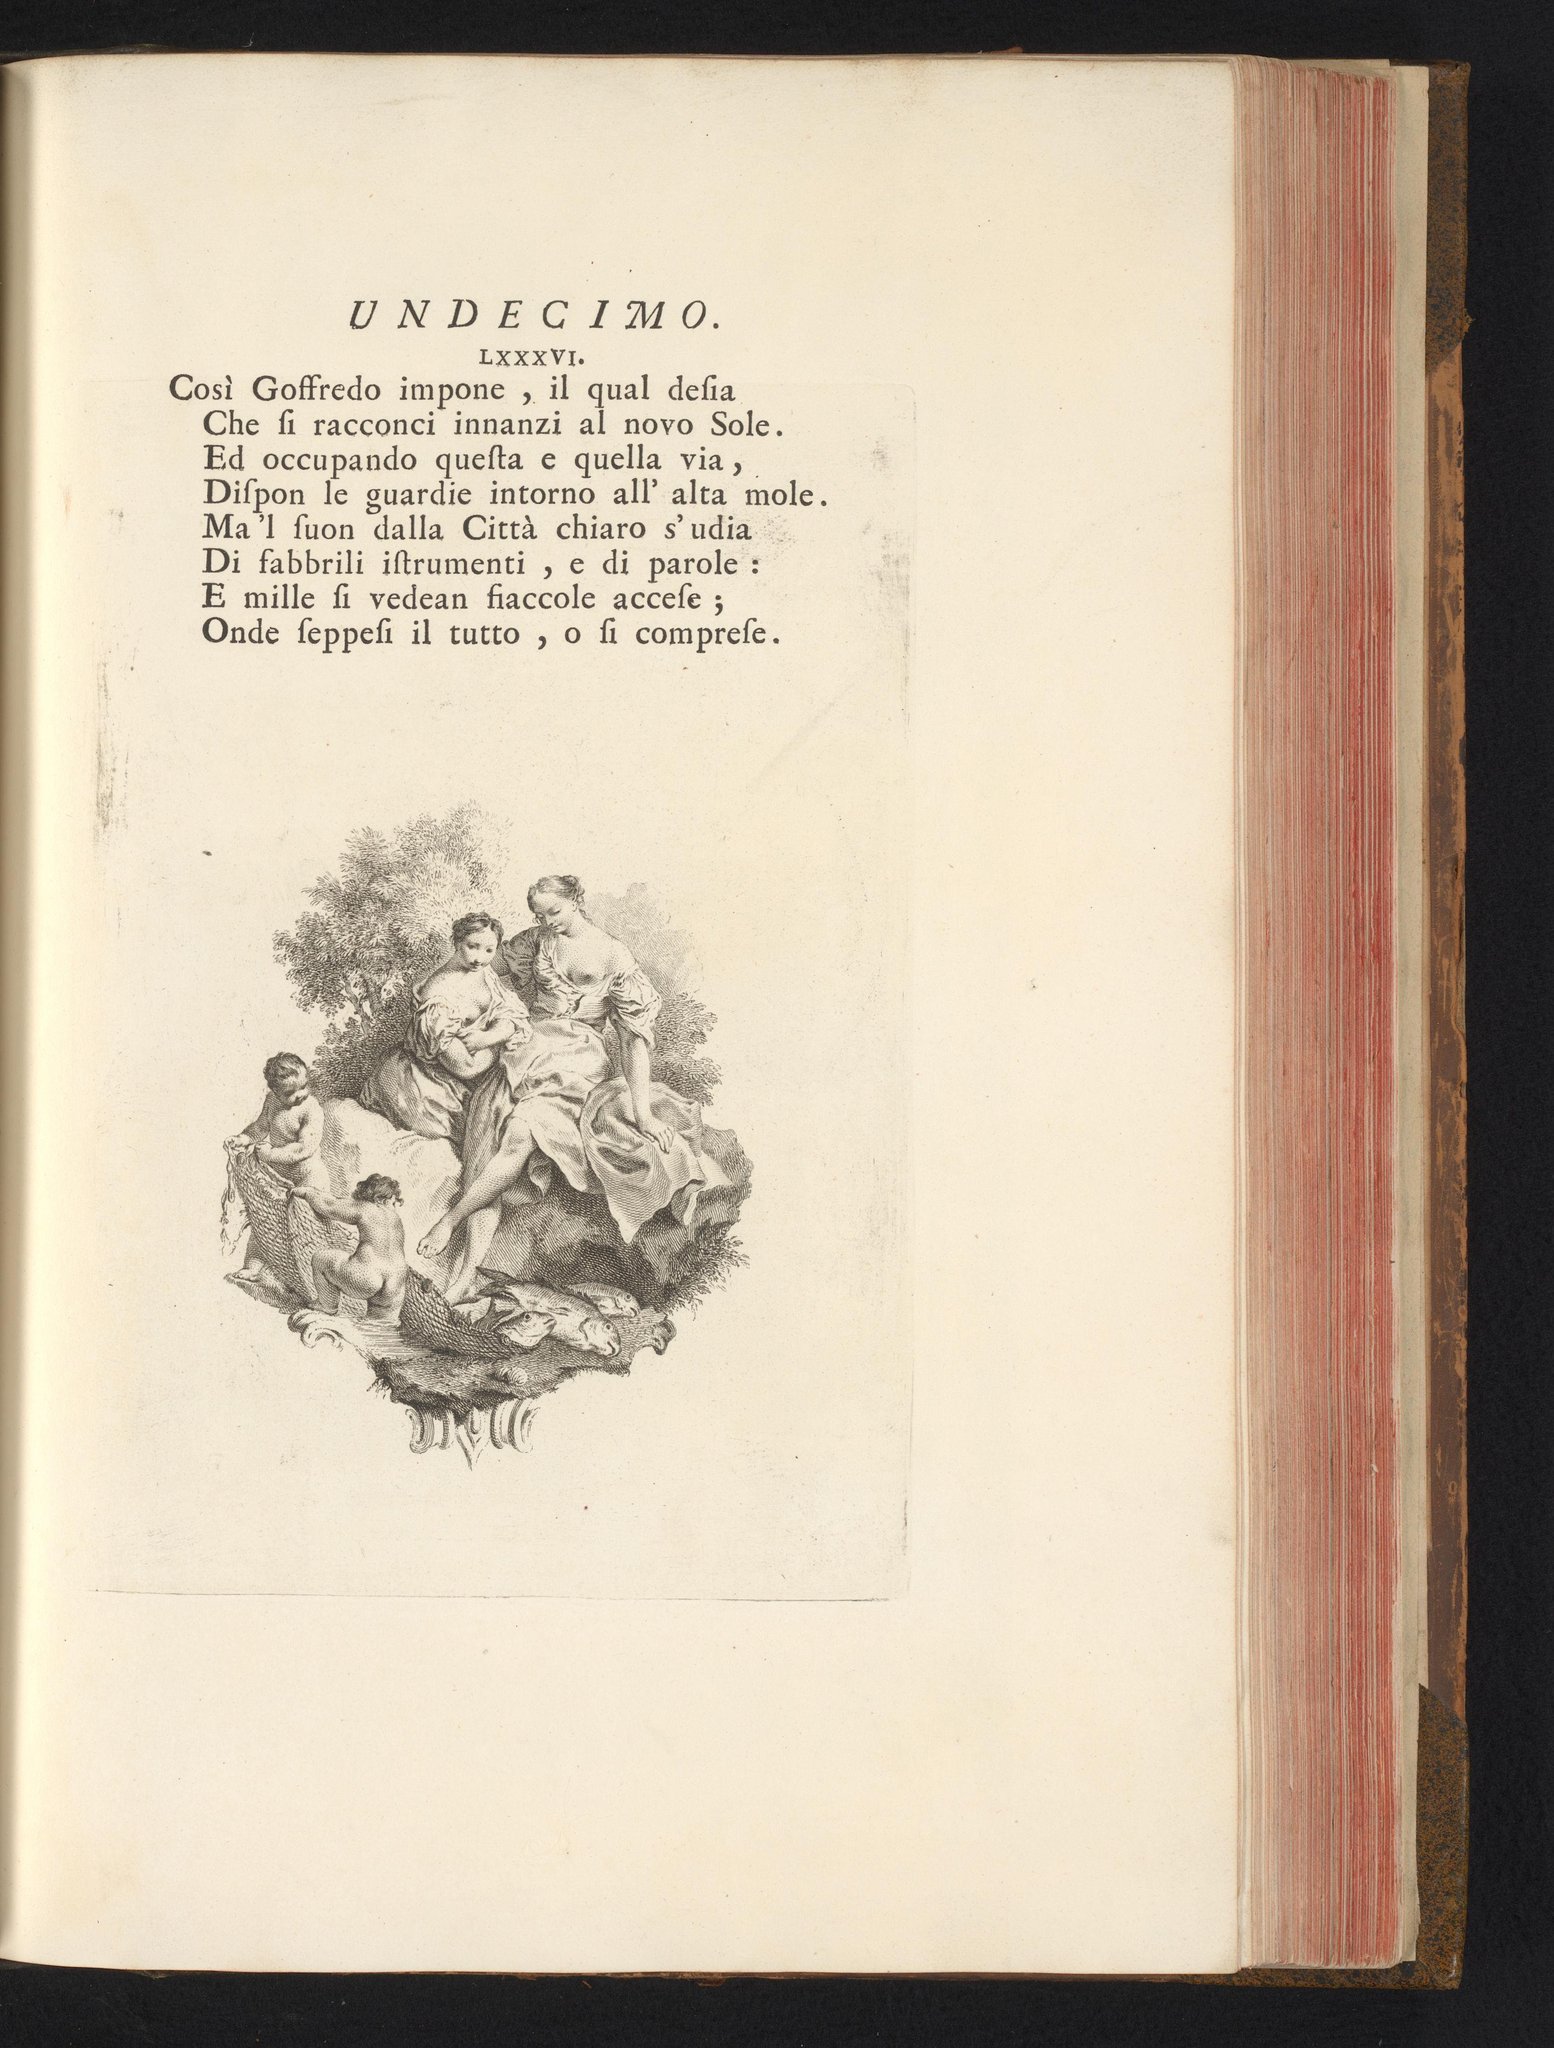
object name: book illustration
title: Twee vrouwen en putti met een mand vis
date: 1745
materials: paper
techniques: etching, letterpress printing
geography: venice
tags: fisherman showing catch, (scenes from) specific works of literature: tasso, gerusalemme liberata, cupids: 'amores', 'amoretti', 'putti'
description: Prent uit: Tasso, Torquato. La Gerusalemme liberata di Torquato Tasso con le figure de Giambatista Piazzetta. Venetië: Giambatista Albrizzi, 1745.